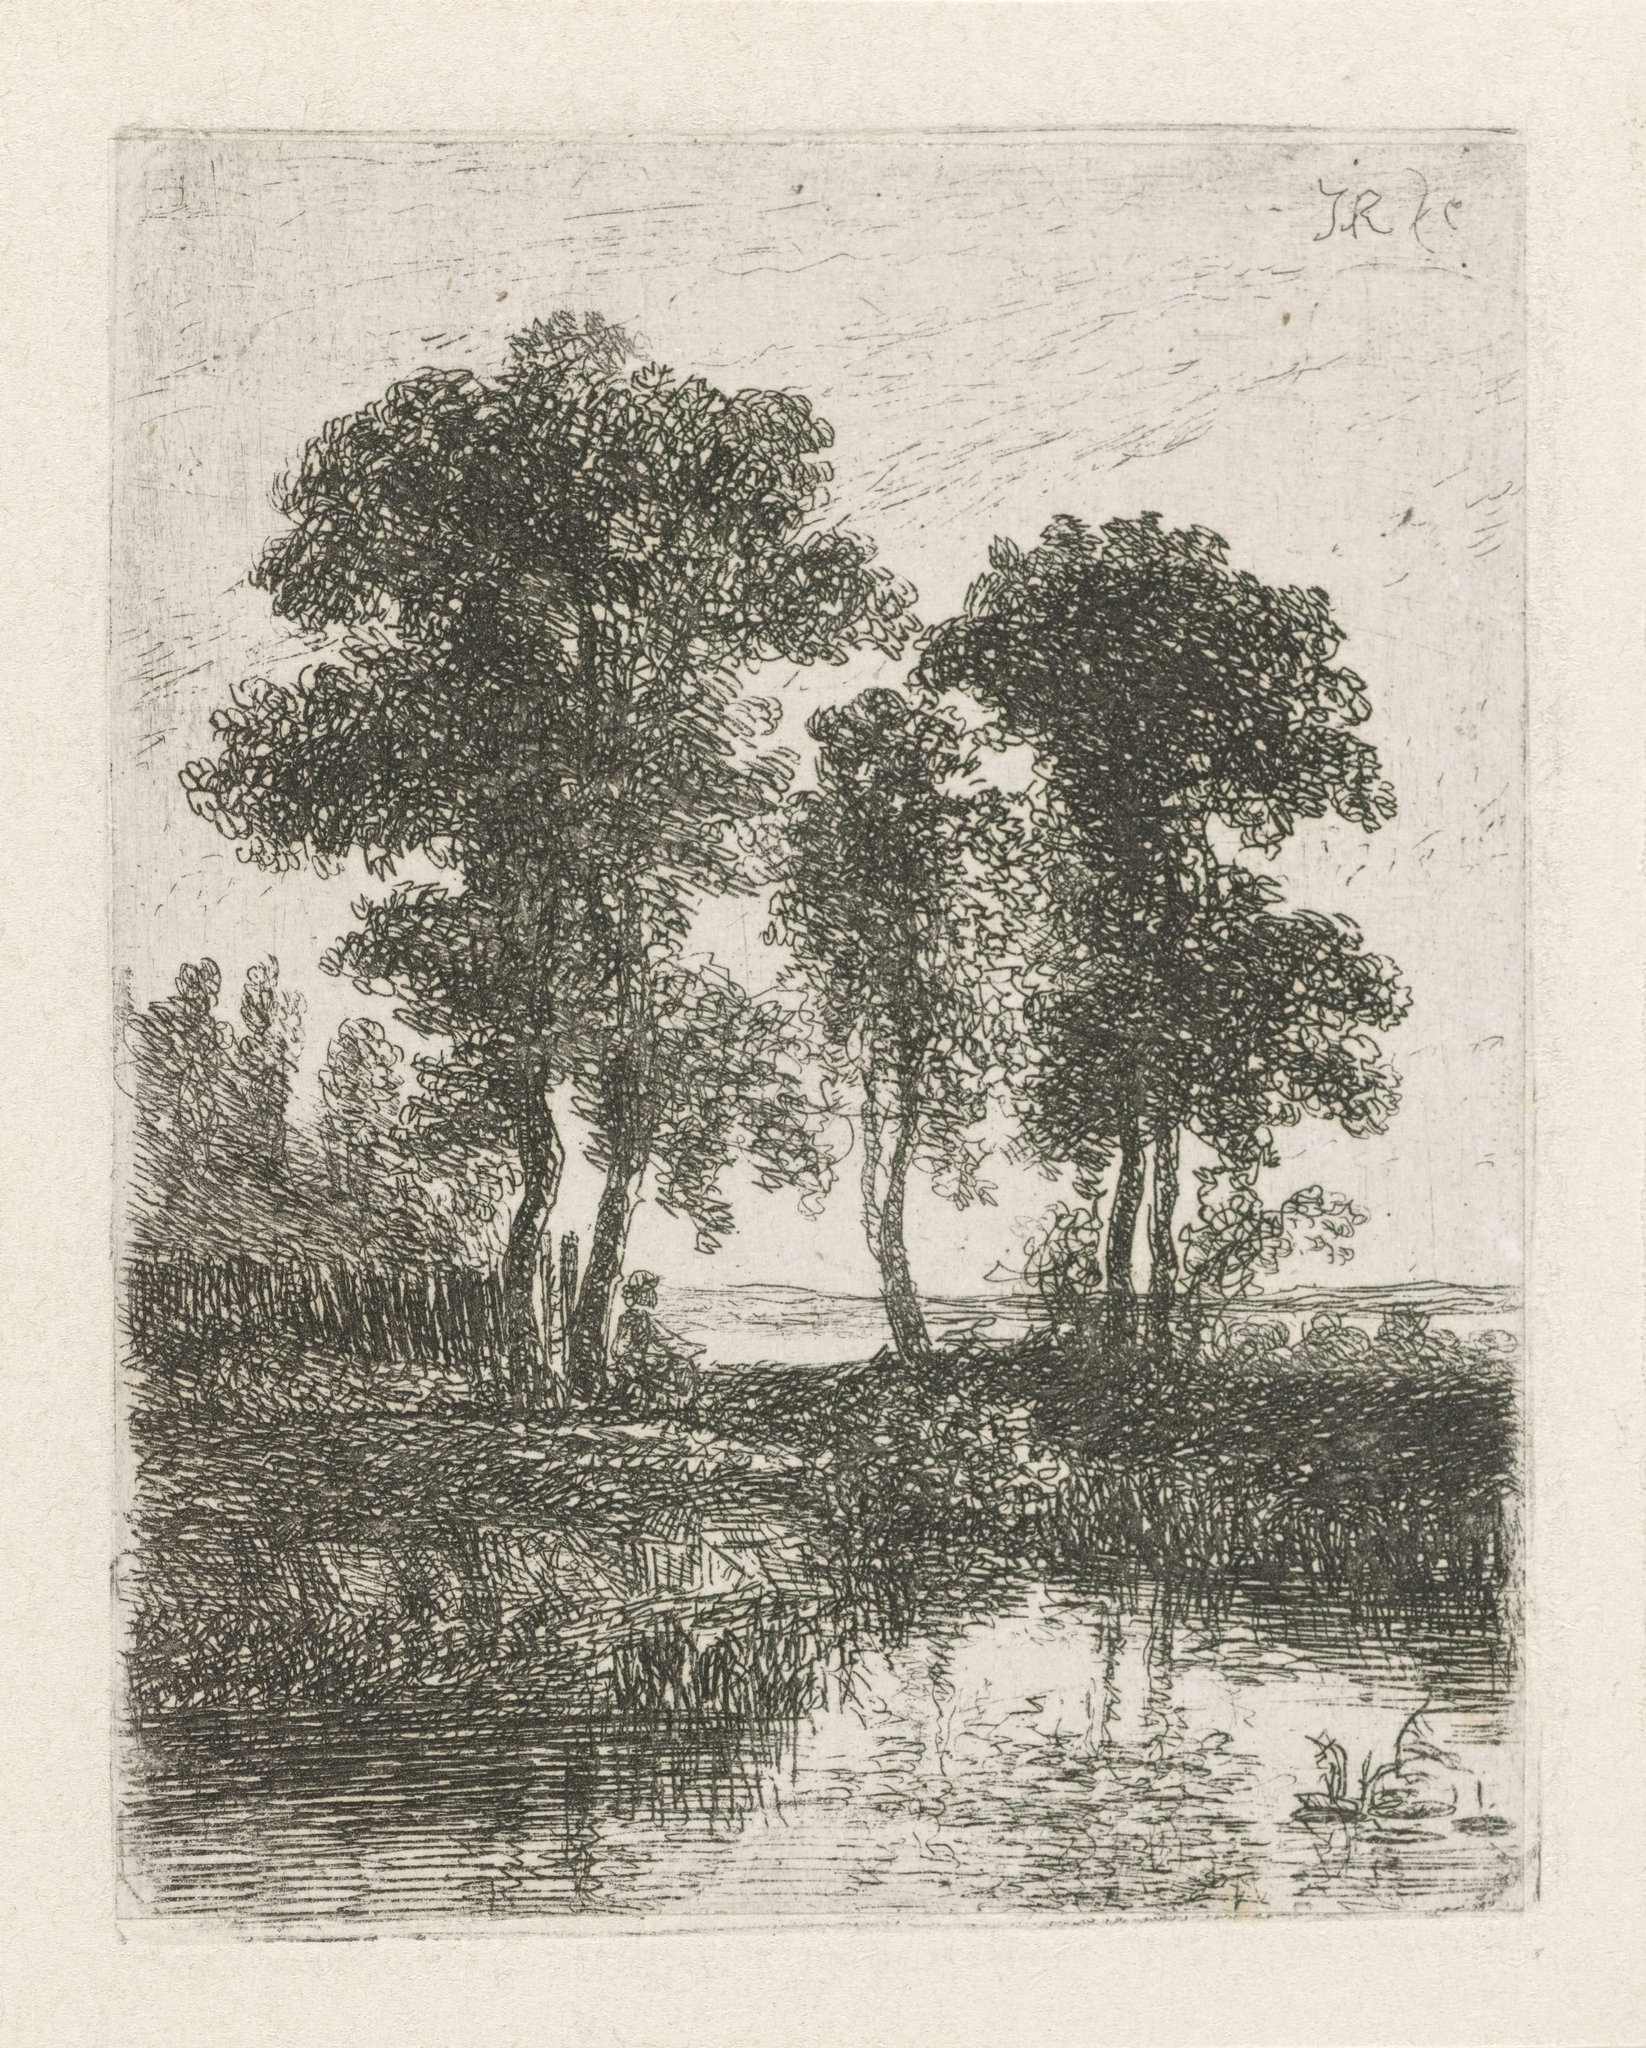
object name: print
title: Figuur bij een boom aan de waterkant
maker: hermanus jan hendrik van rijkelijkhuysen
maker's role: painter, print maker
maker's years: 1813-1883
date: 1823-1883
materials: paper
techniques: etching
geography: utrecht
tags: trees, flowers: water-lily, canal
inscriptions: collector's mark: Lugt 2228